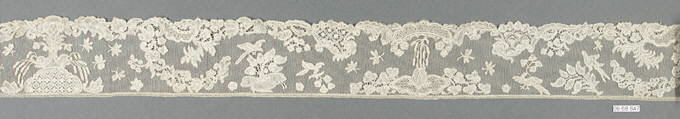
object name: border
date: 1701-1800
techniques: lace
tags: birds,insects